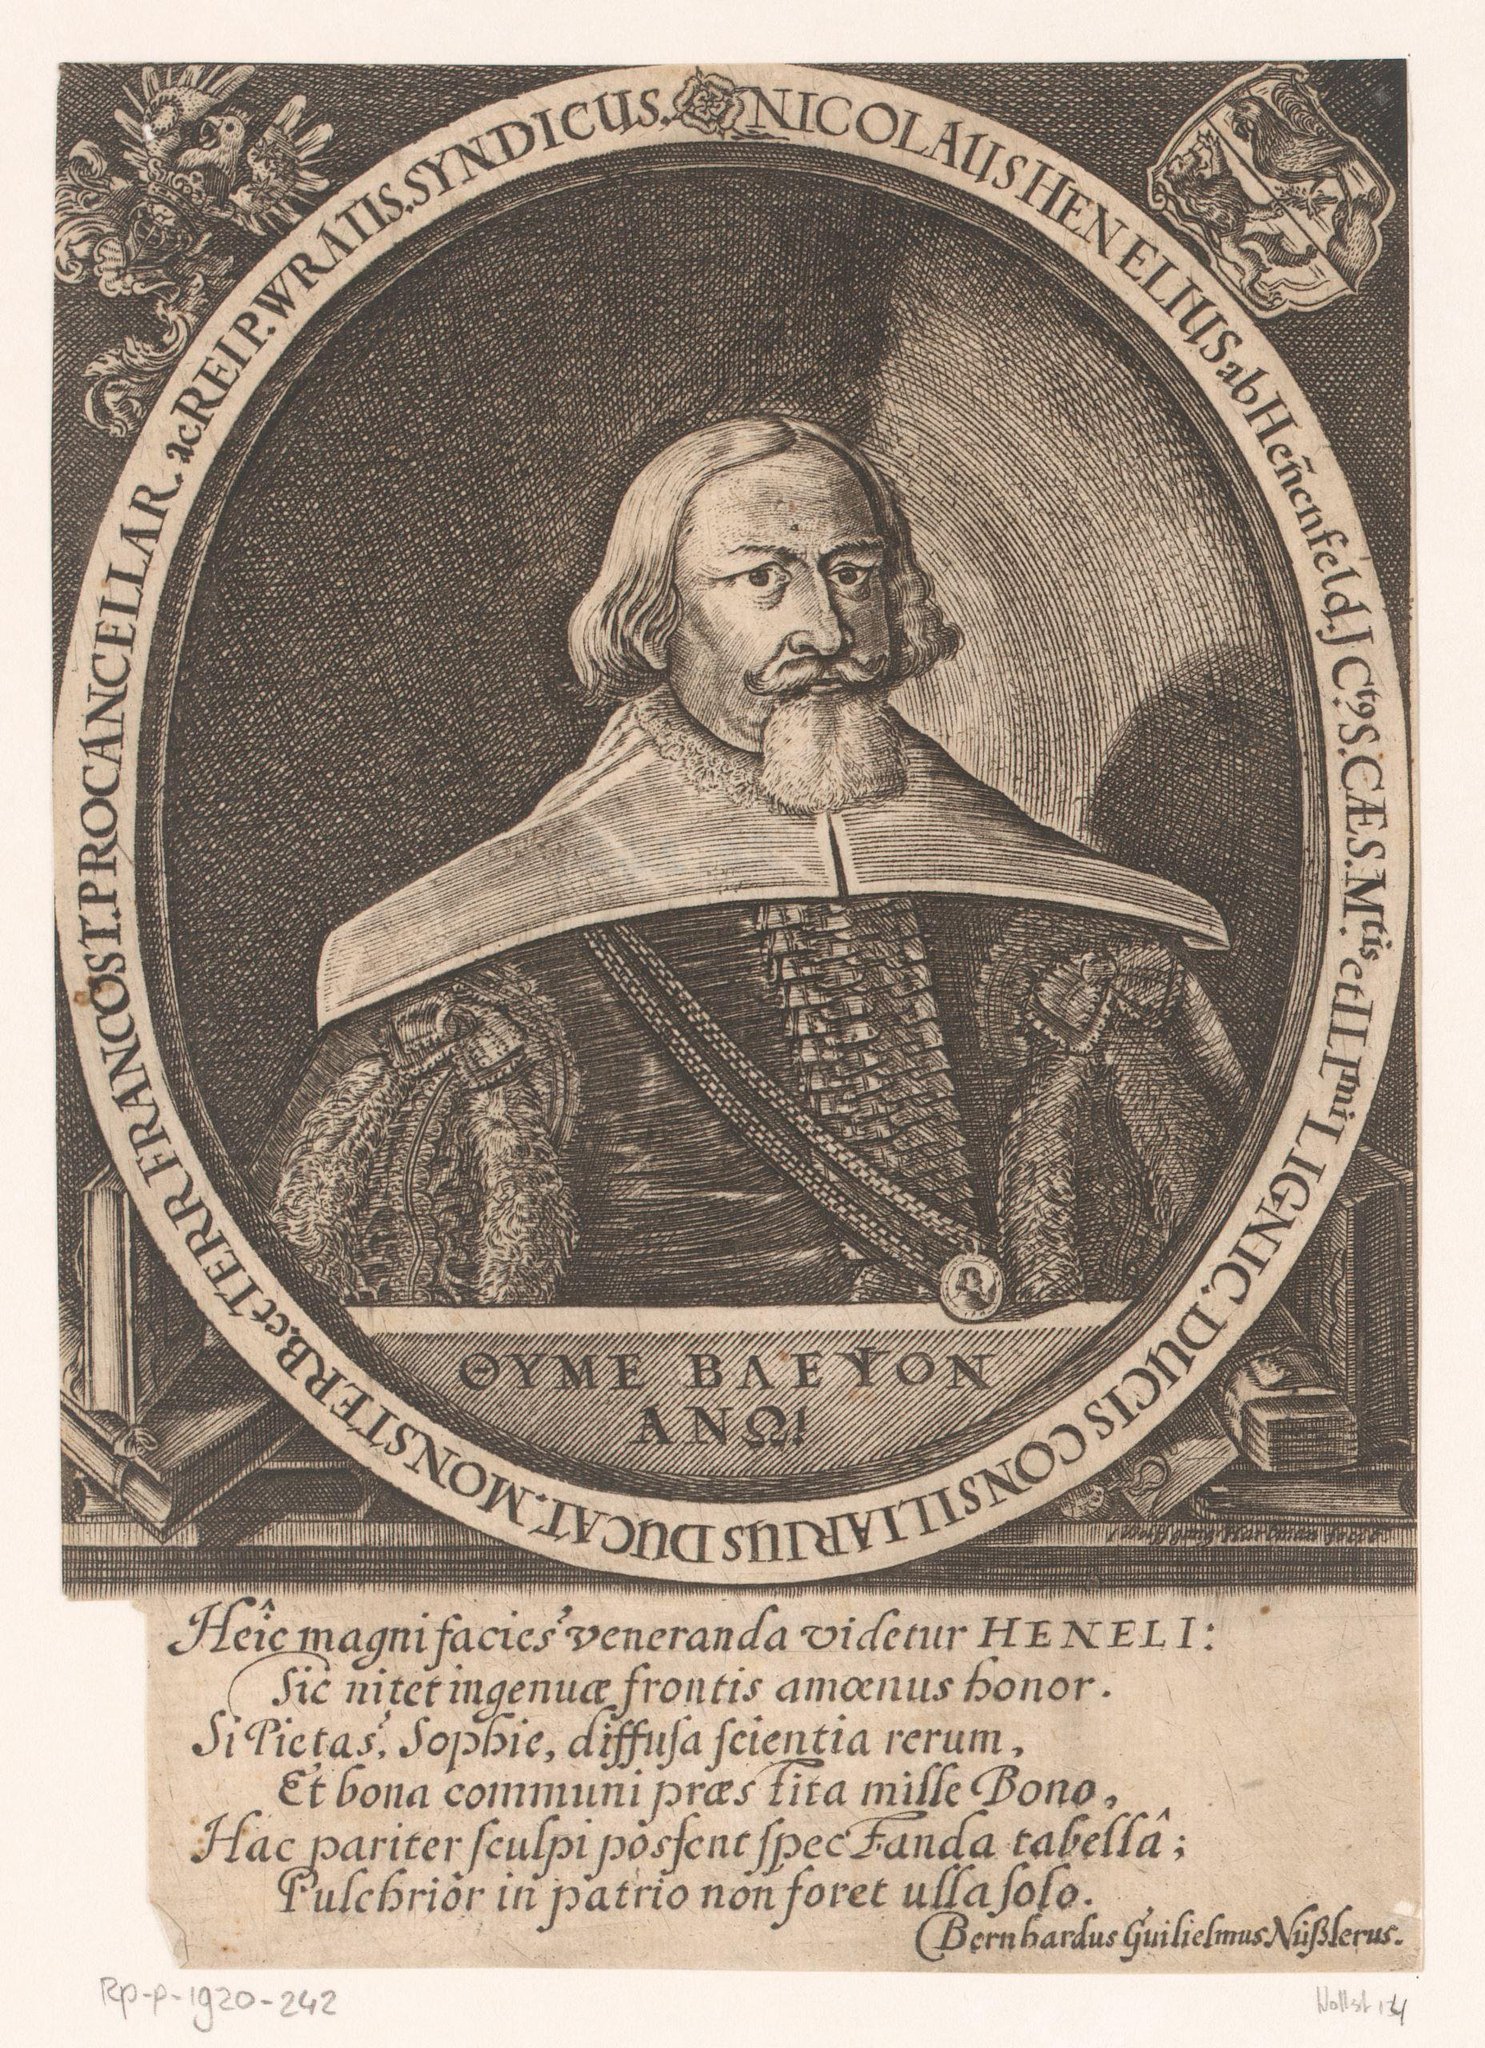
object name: print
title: Portret van Nikolaus Henel von Hennenfeld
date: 1660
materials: paper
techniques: engraving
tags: ornament ~ medallion, historical persons, pendant, trinket, 'breloque', book, armorial bearing, heraldry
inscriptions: collector's mark: Lugt 2228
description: Prent gebruikt voor: Henel von Hennenfeld, Nikolaus. Tractatus de Jure dotalitii. Frankfurt en Leipzig: Esaias Fellgibel, 1660.